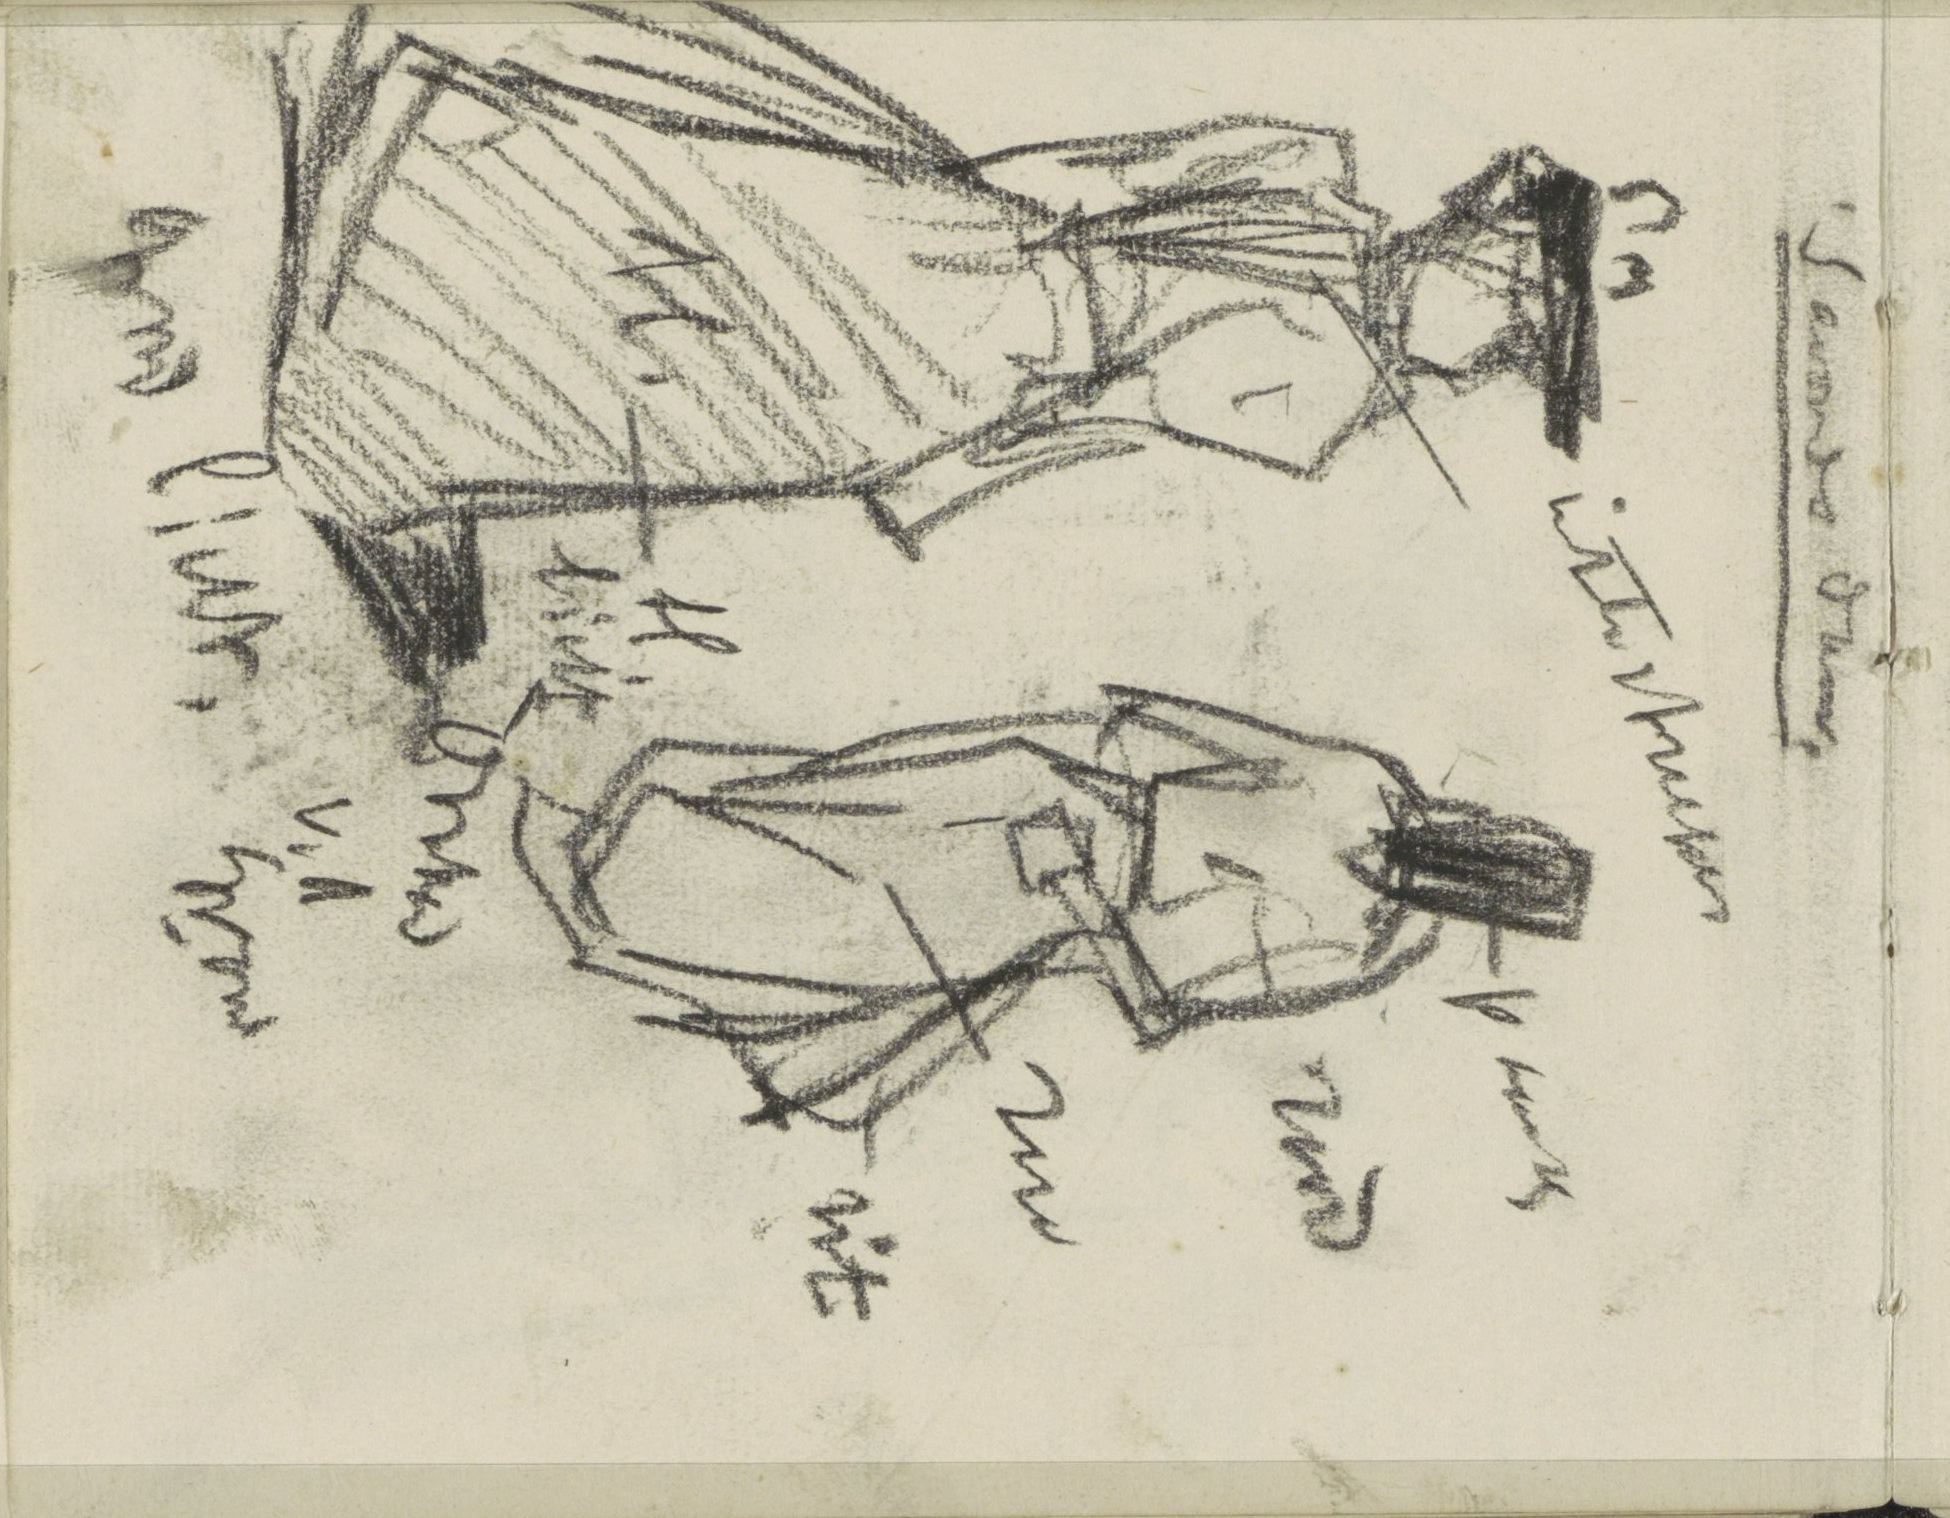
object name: sketchbook leaf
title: Twee vrouwen op de Dam te Amsterdam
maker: george hendrik breitner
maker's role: draughtsman, painter, print maker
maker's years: 1857-1923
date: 1893-1912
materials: chalk, paper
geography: amsterdam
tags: adult woman (+ two persons)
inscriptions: annotation: ‘'s avonds Dam’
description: Pagina 55 uit een schetsboek met 32 bladen.